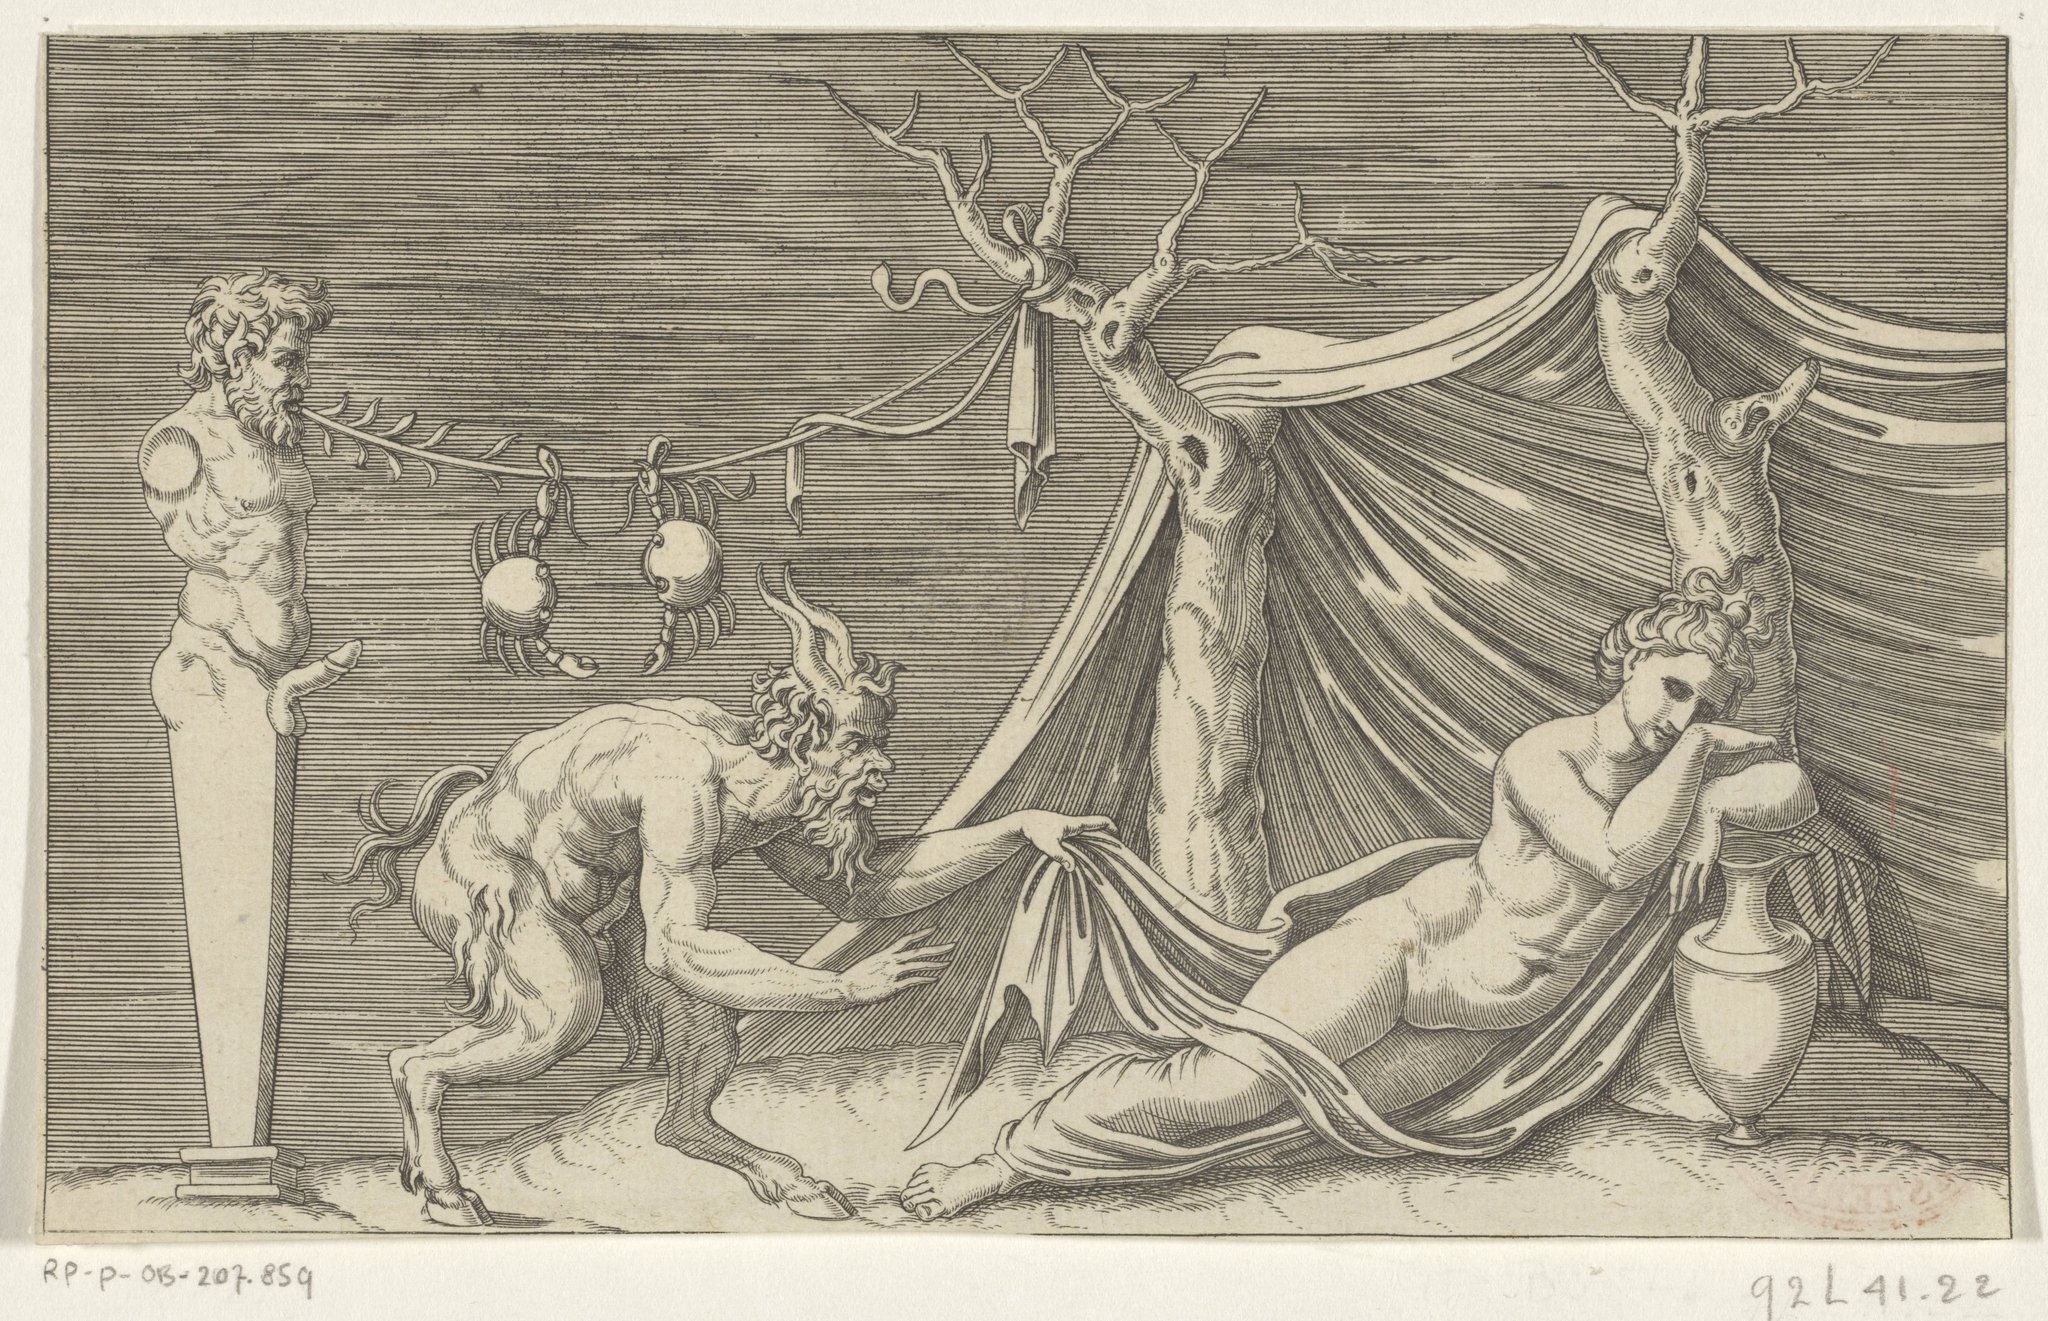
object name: print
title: Sater bespiedt een nimf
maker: marco dente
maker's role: print maker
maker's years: 1486-1527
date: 1496-1527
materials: paper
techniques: engraving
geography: italy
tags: satyr(s) spying upon, priapus-herm, crustaceans: crab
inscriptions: collector's mark: Lugt 12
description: Een sater sluipt richting een nimf die rechts met haar armen op een vaas ligt te slapen. Links staat de vruchtbaarheidsgod Priapus als herme en boven de sater hangen twee krabben.